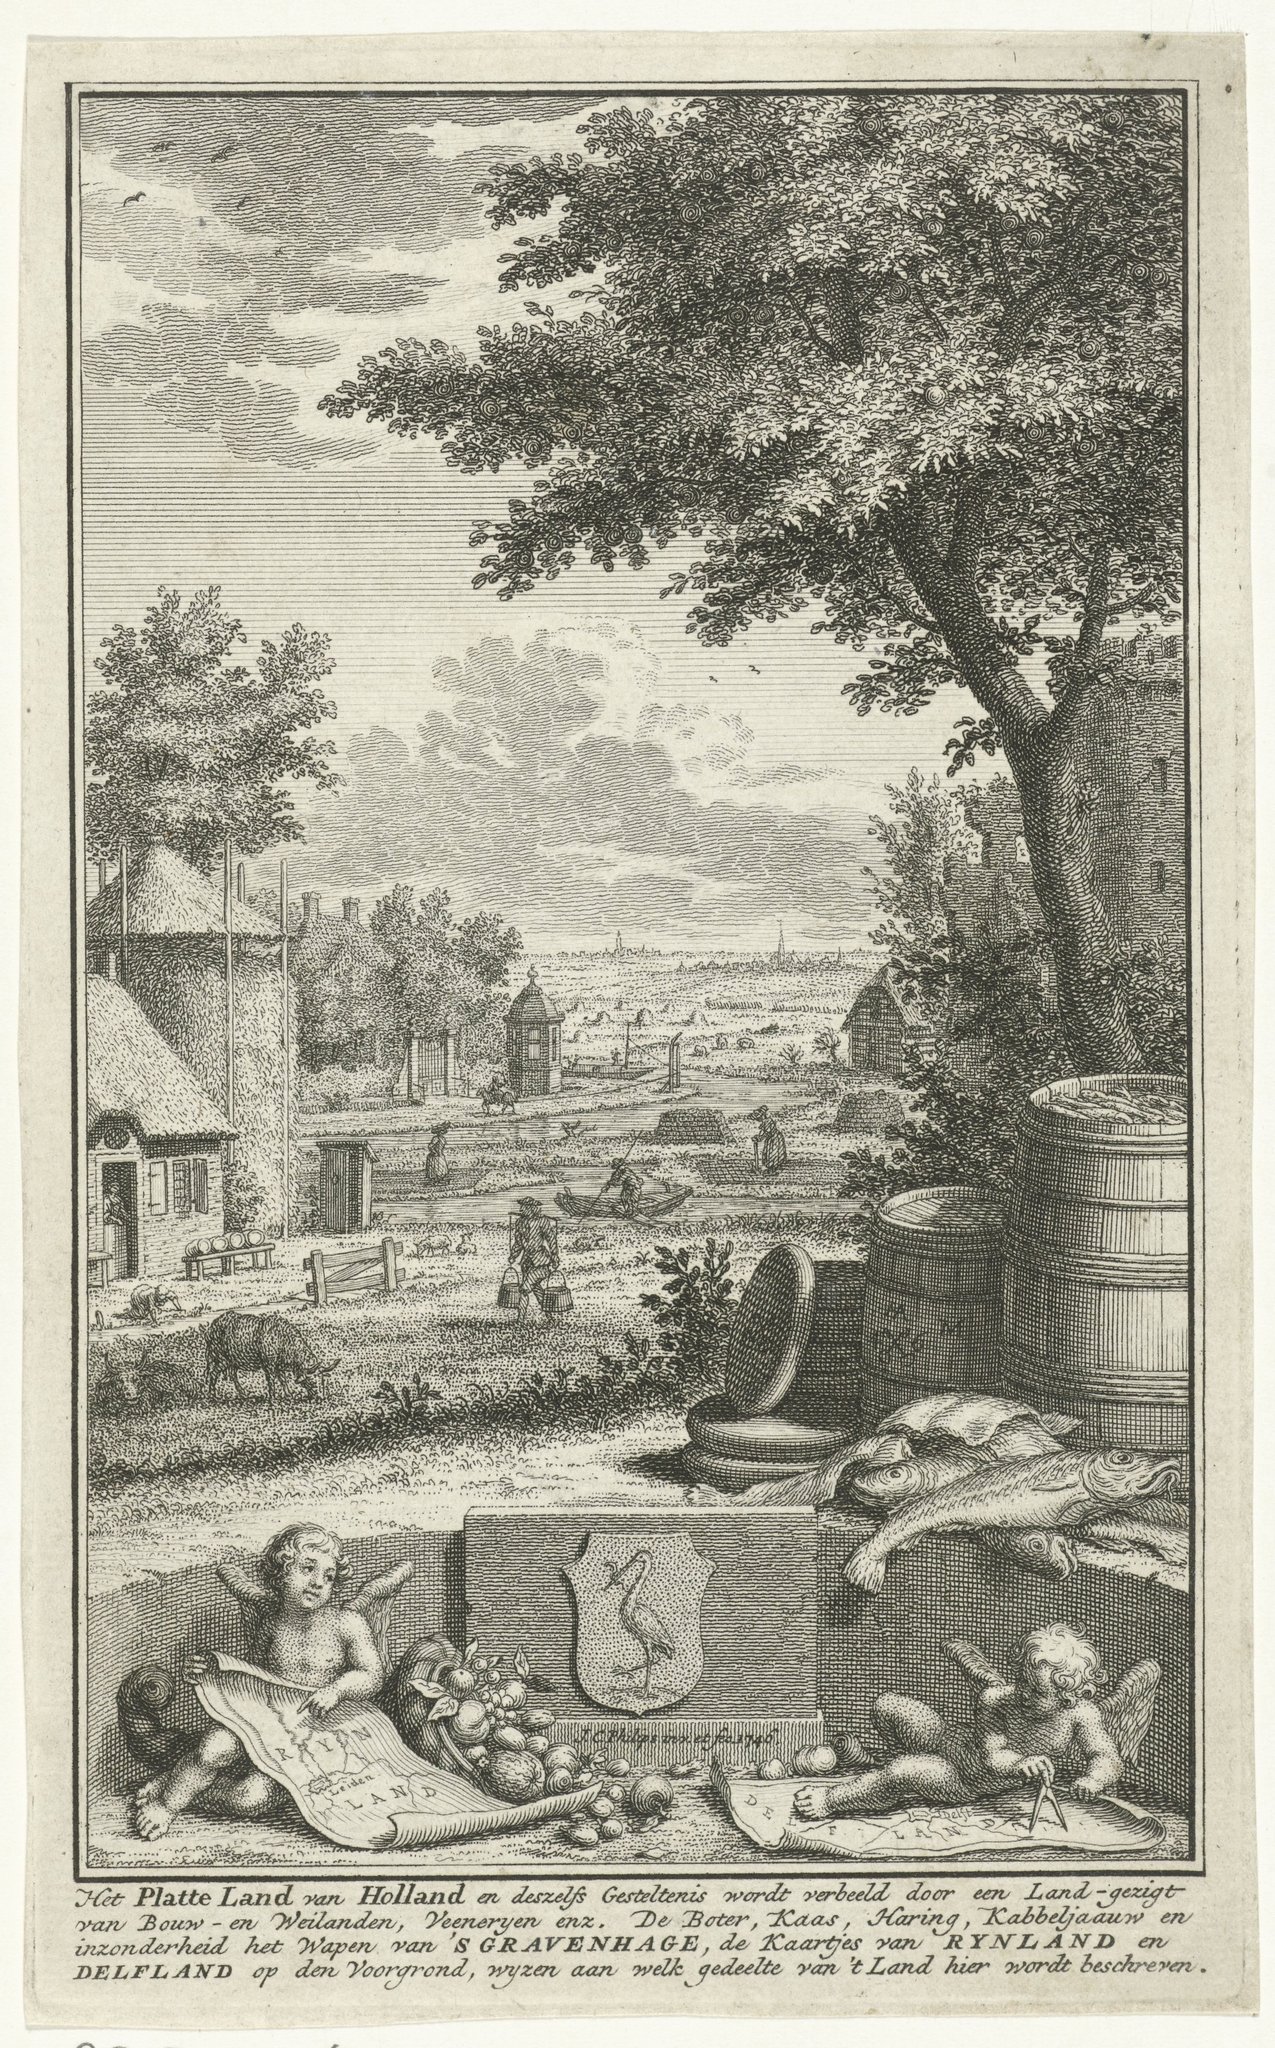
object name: print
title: Titelpagina voor: T. Salmon, Behelzende Het Vervolg Der Beschryvinge Van Holland, 1746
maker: jan caspar philips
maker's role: draughtsman, print maker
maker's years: 1700-1775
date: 1746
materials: paper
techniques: engraving, etching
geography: amsterdam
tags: maps, atlases, meadow, pasture, coat of arms (as symbol of the state, etc.) (+ province; provincial), the hague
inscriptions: collector's mark: Lugt 2228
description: Gezicht op een rivierlandschap met een boerderij en weilanden. Op de voorgrond het wapenschild van 's Gravenhage en twee putti met landkaarten. In de marge een vierregelig onderschrift in het Nederlands.